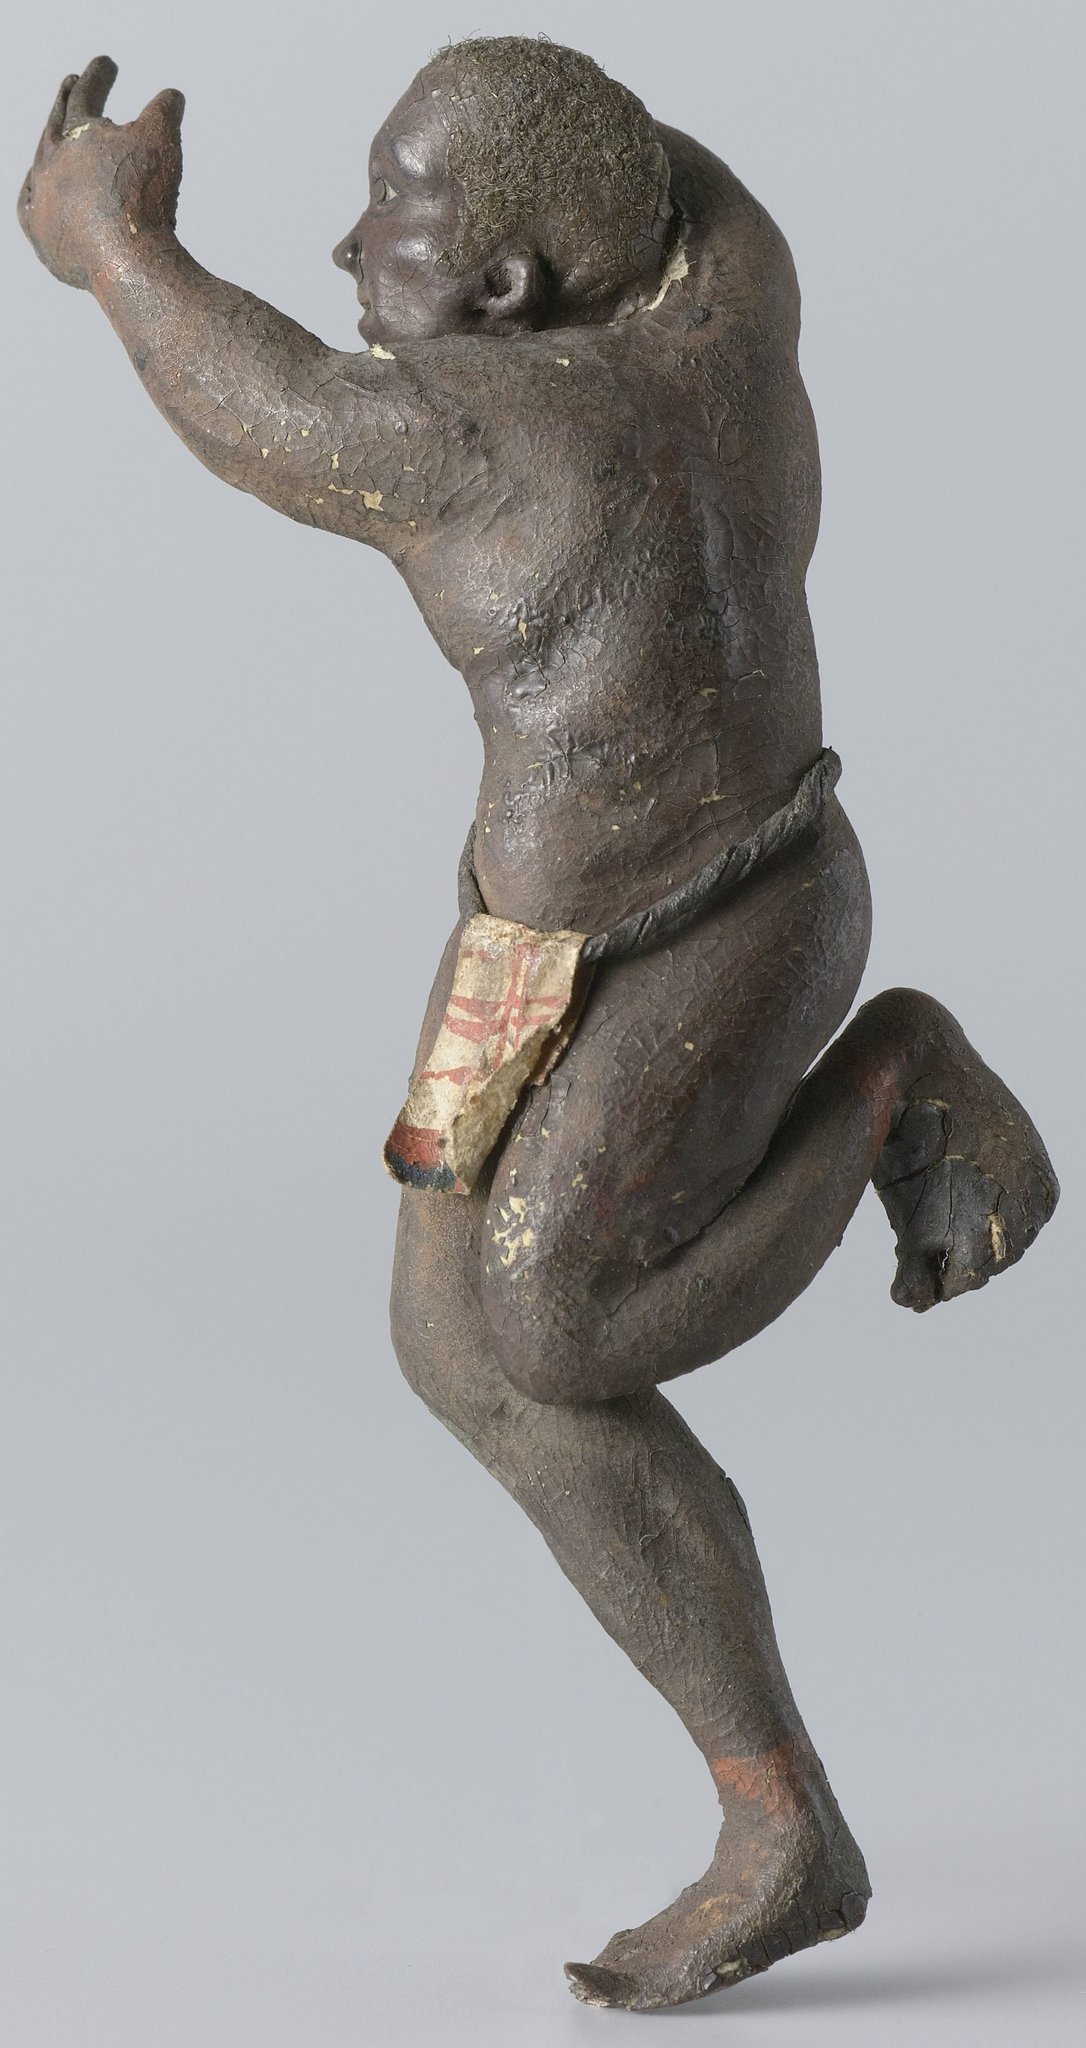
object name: figure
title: Een man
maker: gerrit schouten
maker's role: draughtsman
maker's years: 1779-1839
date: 1810-1839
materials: glue, paint, paper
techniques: modeling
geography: suriname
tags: suriname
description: Een los figuur uit een diorama van Gerrit Schouten, voorstellende een man, staand op rechterbeen, naar links gewend. Zijn rechterarm opgeheven. Hij draagt een geruite schaamlap.